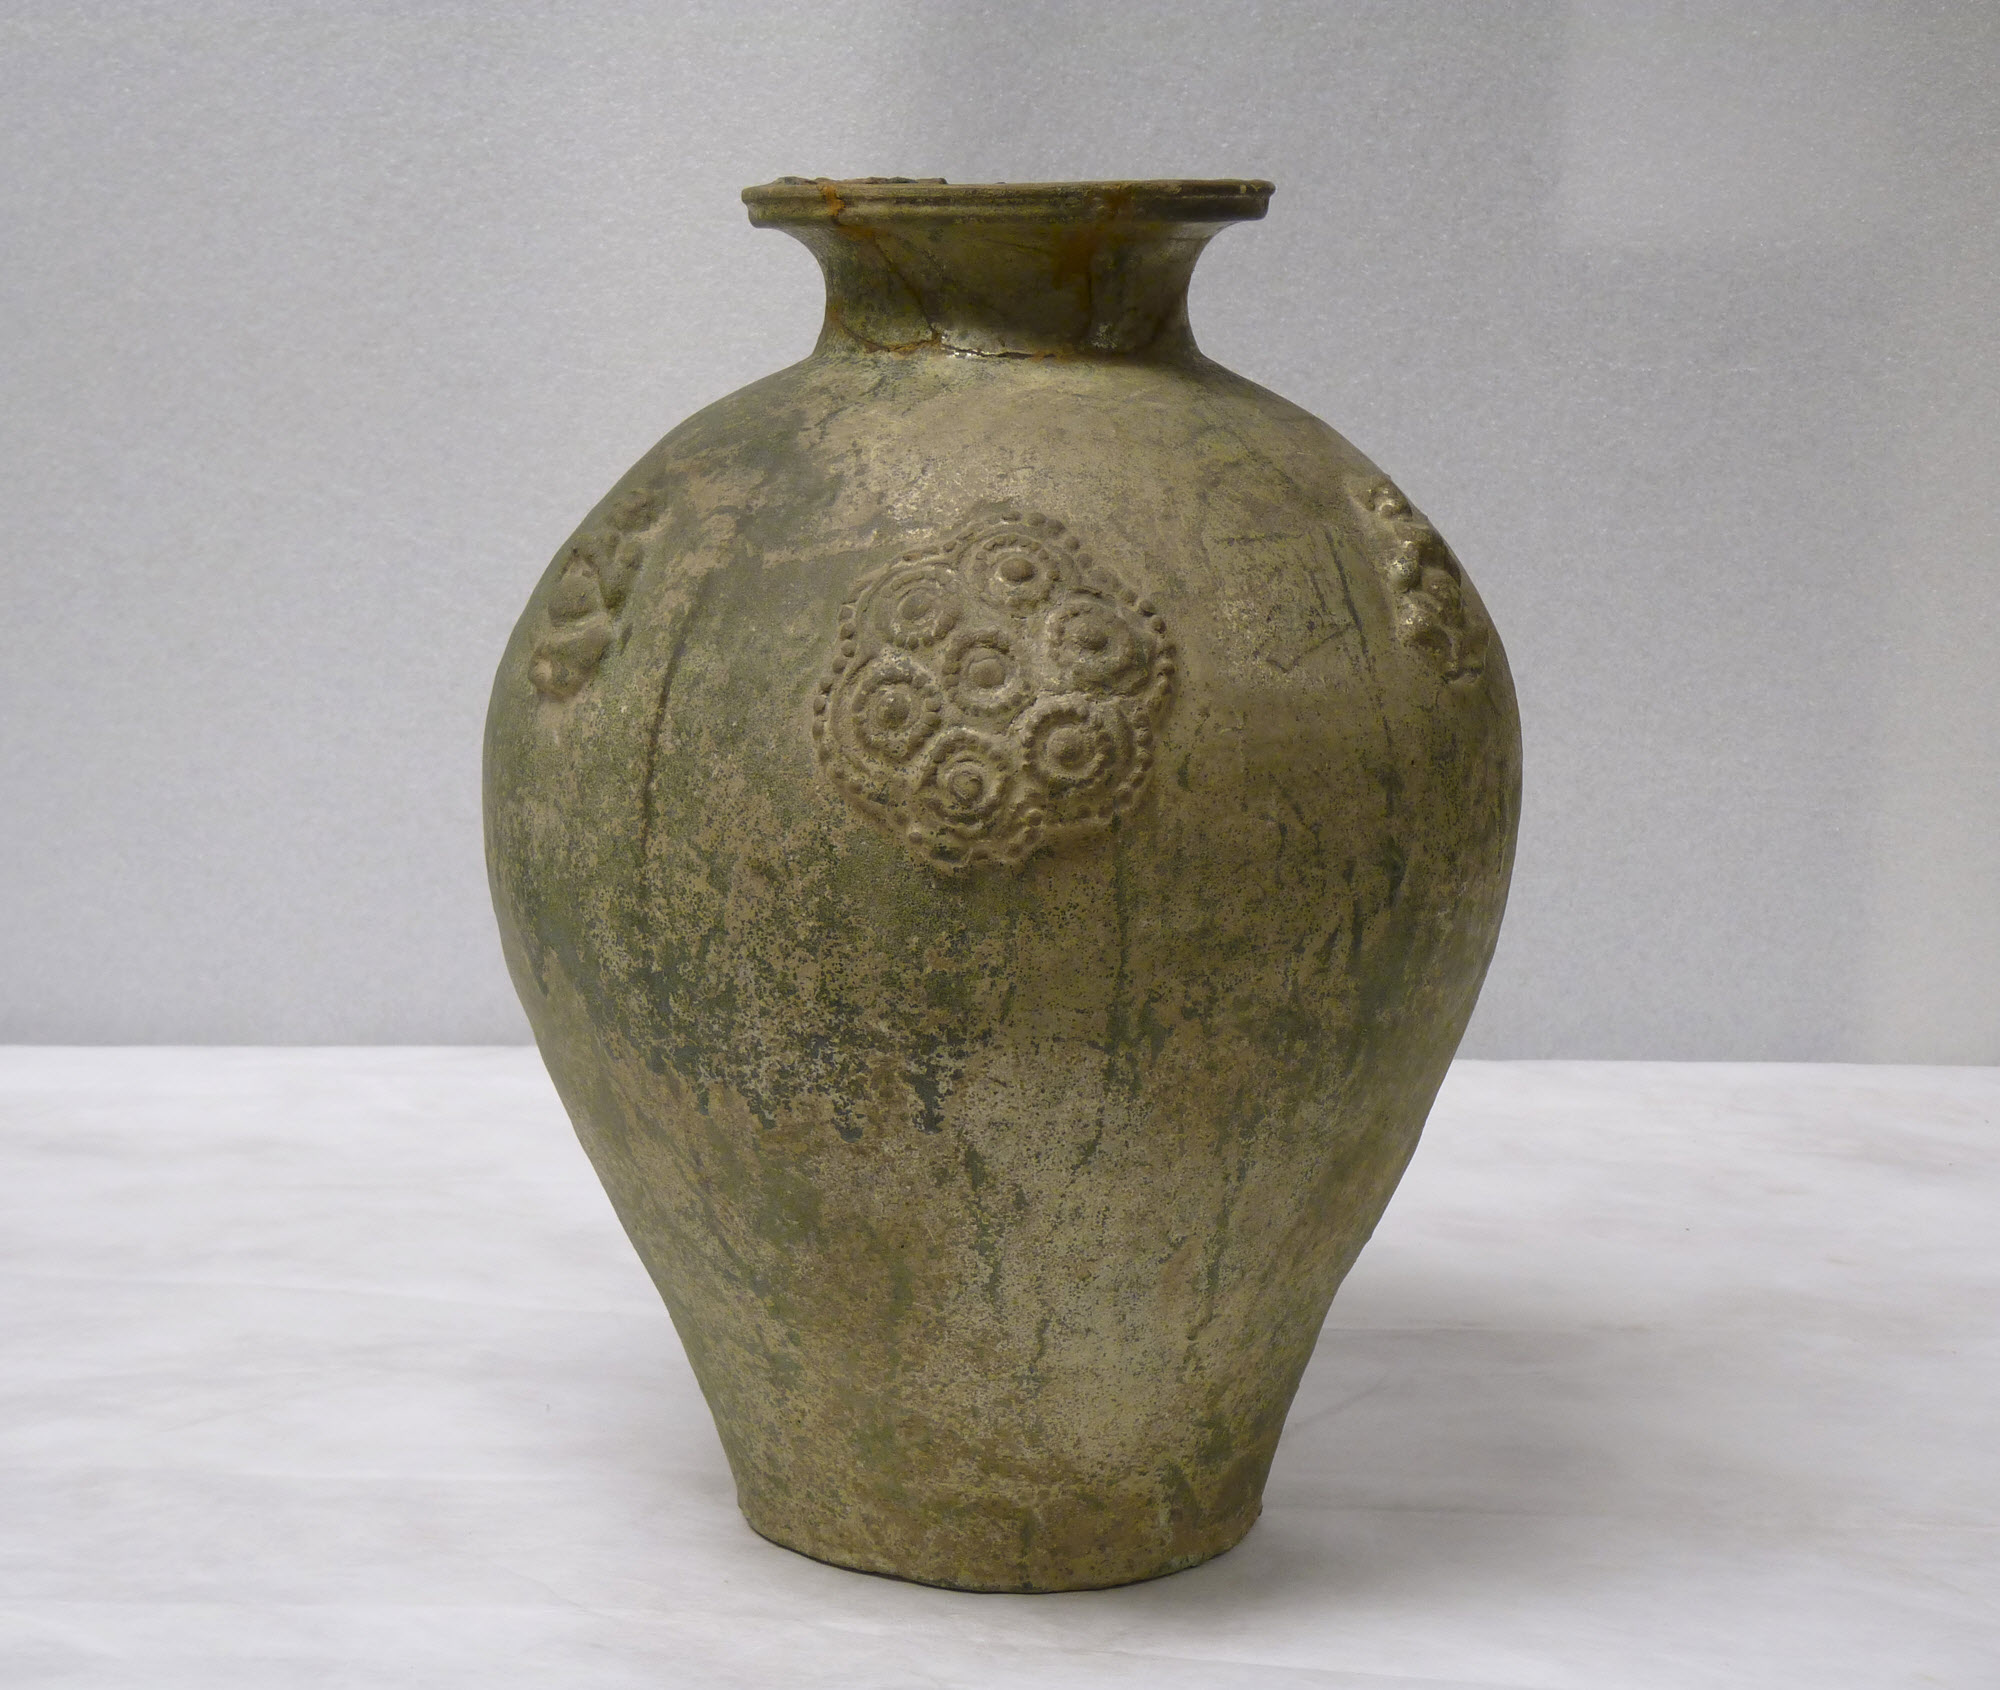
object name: jar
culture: chinese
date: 567-600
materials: earthenware, glaze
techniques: relief